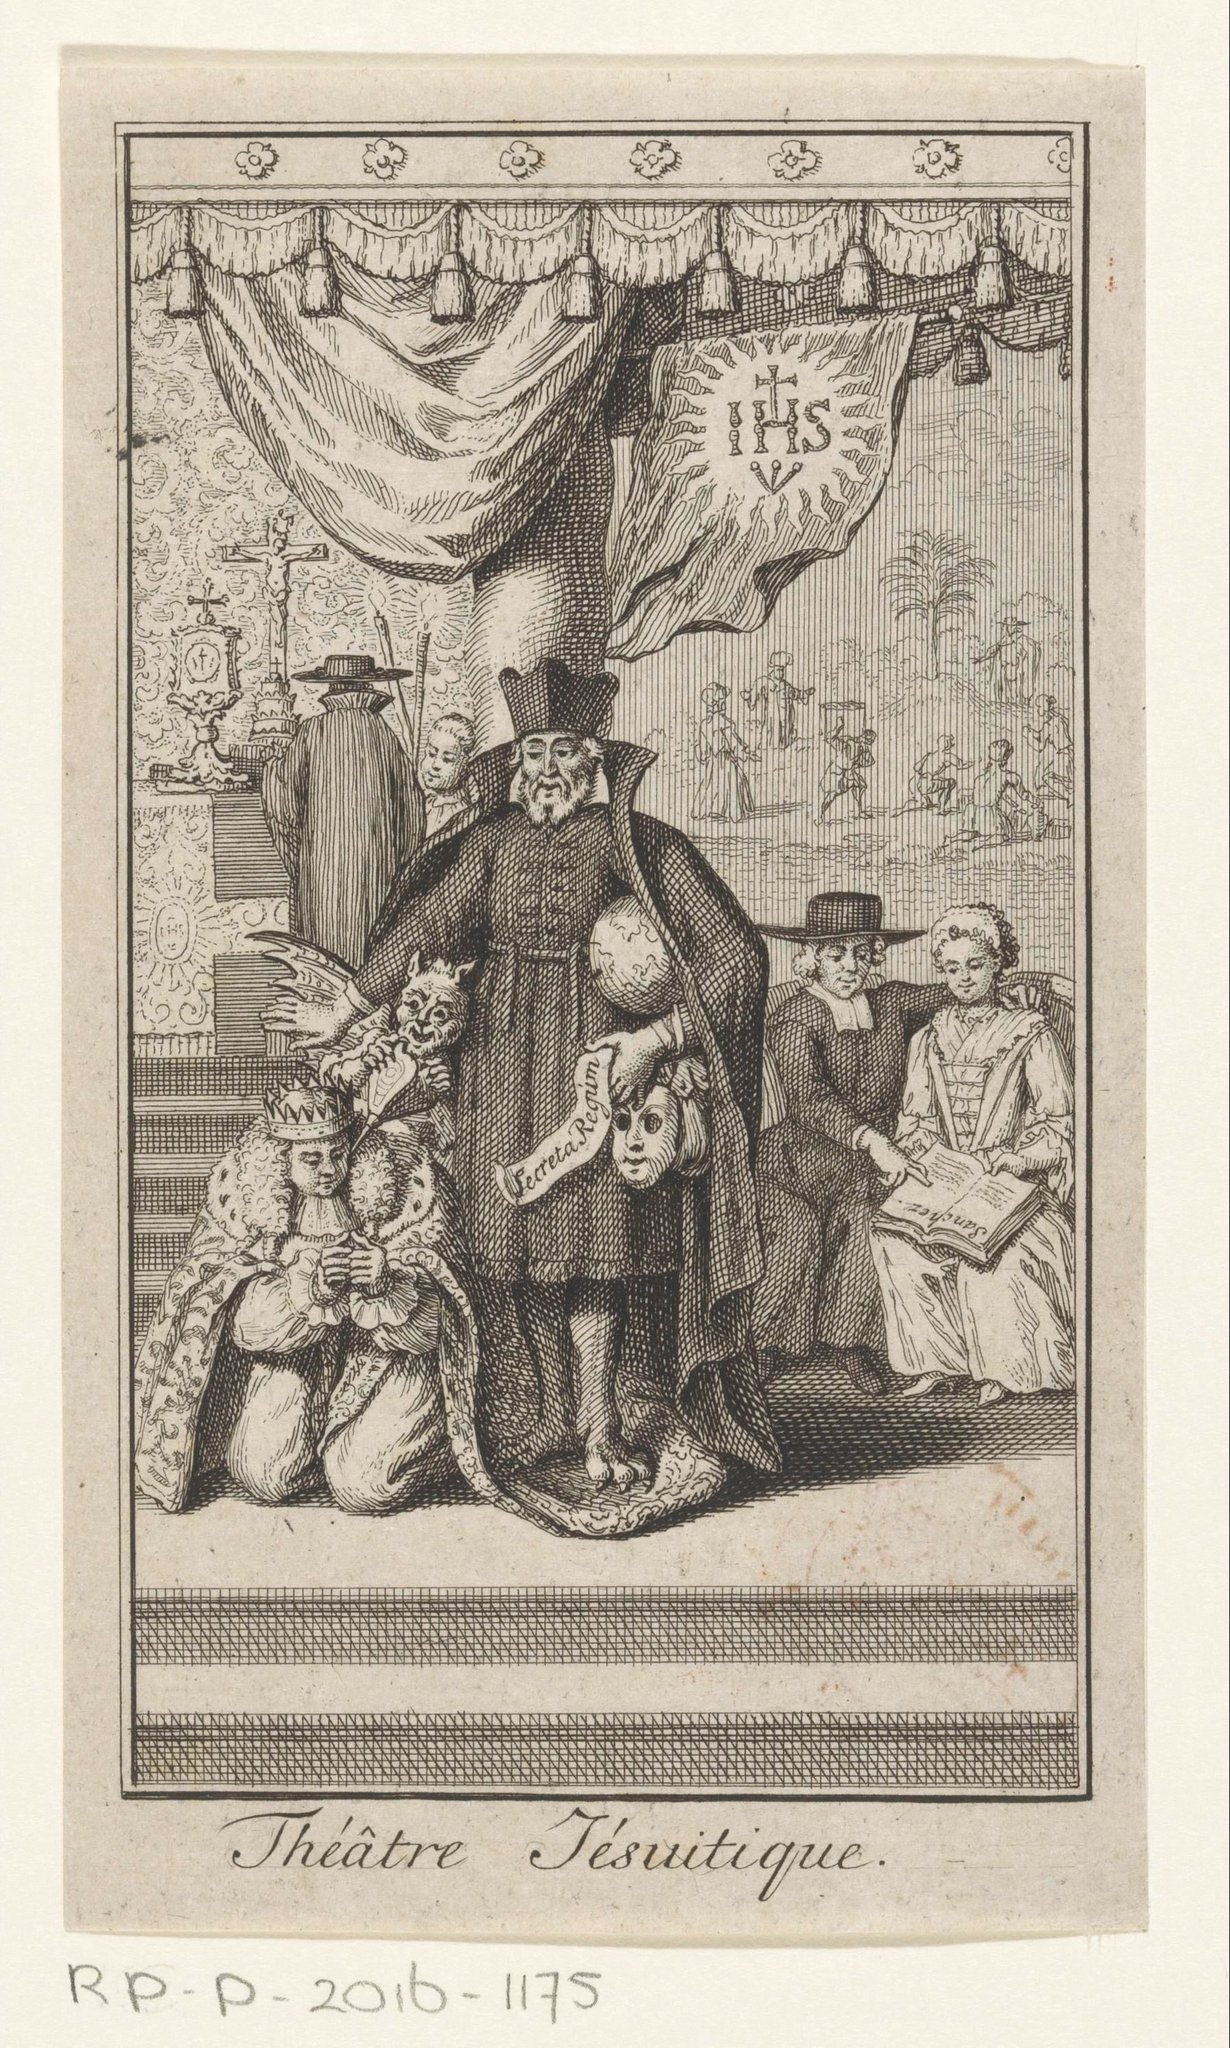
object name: print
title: Allegorische voorstelling met jezuïeten en koning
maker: Anonymous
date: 1700-1799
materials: paper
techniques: etching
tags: regular clerics, e.g. jesuits, redemptorists, king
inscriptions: collector's mark: Lugt 240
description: Een jezuïet met leeuwenpoten draagt een globe, een masker en een papier met Secreta Regim onder zijn arm. Naast hem zit een koning op zijn knieën, bij hem zit een duivelsfiguur met een blaasbalg. Links staat een jezuïet bij een monstrans en kruisbeeld. Rechts leest een jezuïetenpaar in een boek waarin Sanchez geschreven staat. Boven hen hangt een banier met de letters IHS.